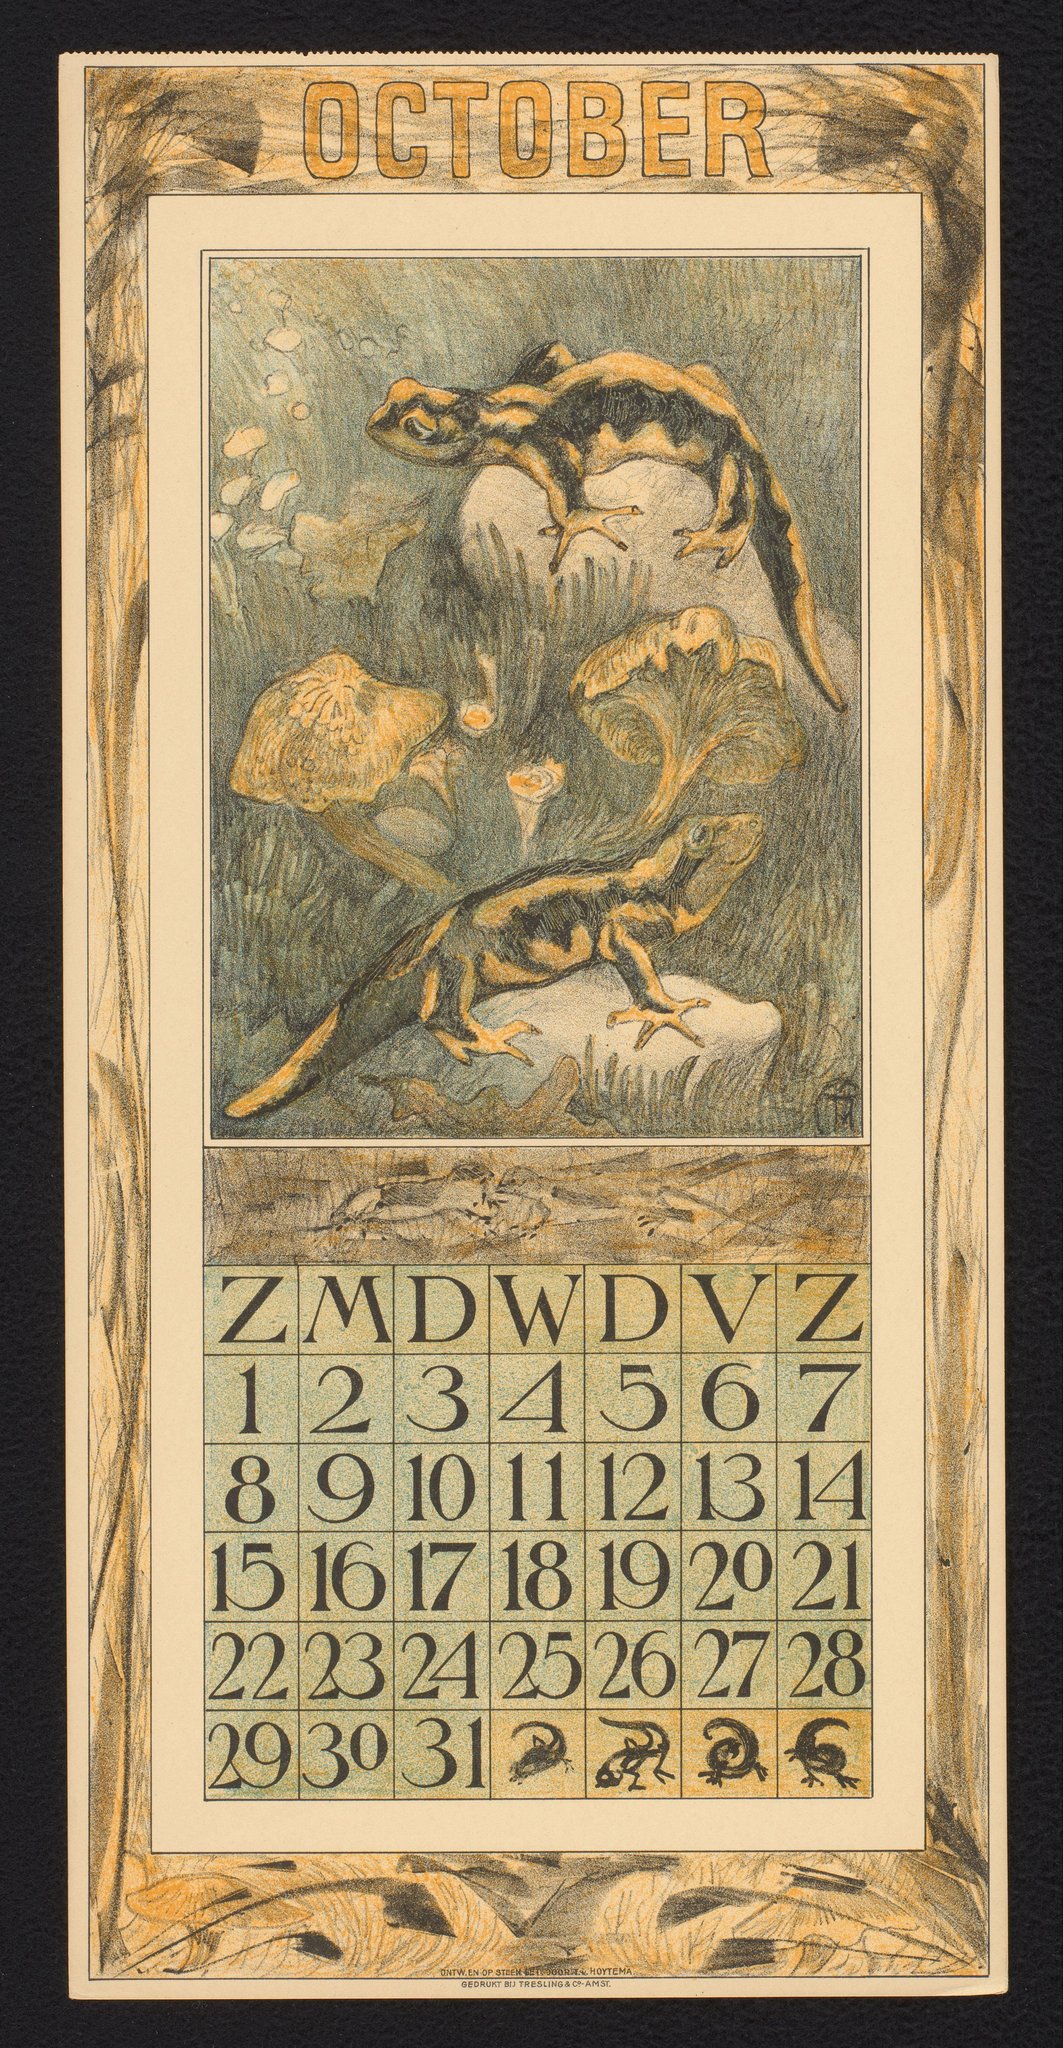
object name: print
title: Kalenderblad voor oktober 1911 met salamanders en paddenstoelen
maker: theo van hoytema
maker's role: draughtsman, painter, print maker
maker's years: 1863-1917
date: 1910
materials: paper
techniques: lithograph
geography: amsterdam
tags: calendar, almanac, lizards, mushrooms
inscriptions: collector's mark: Lugt 2228